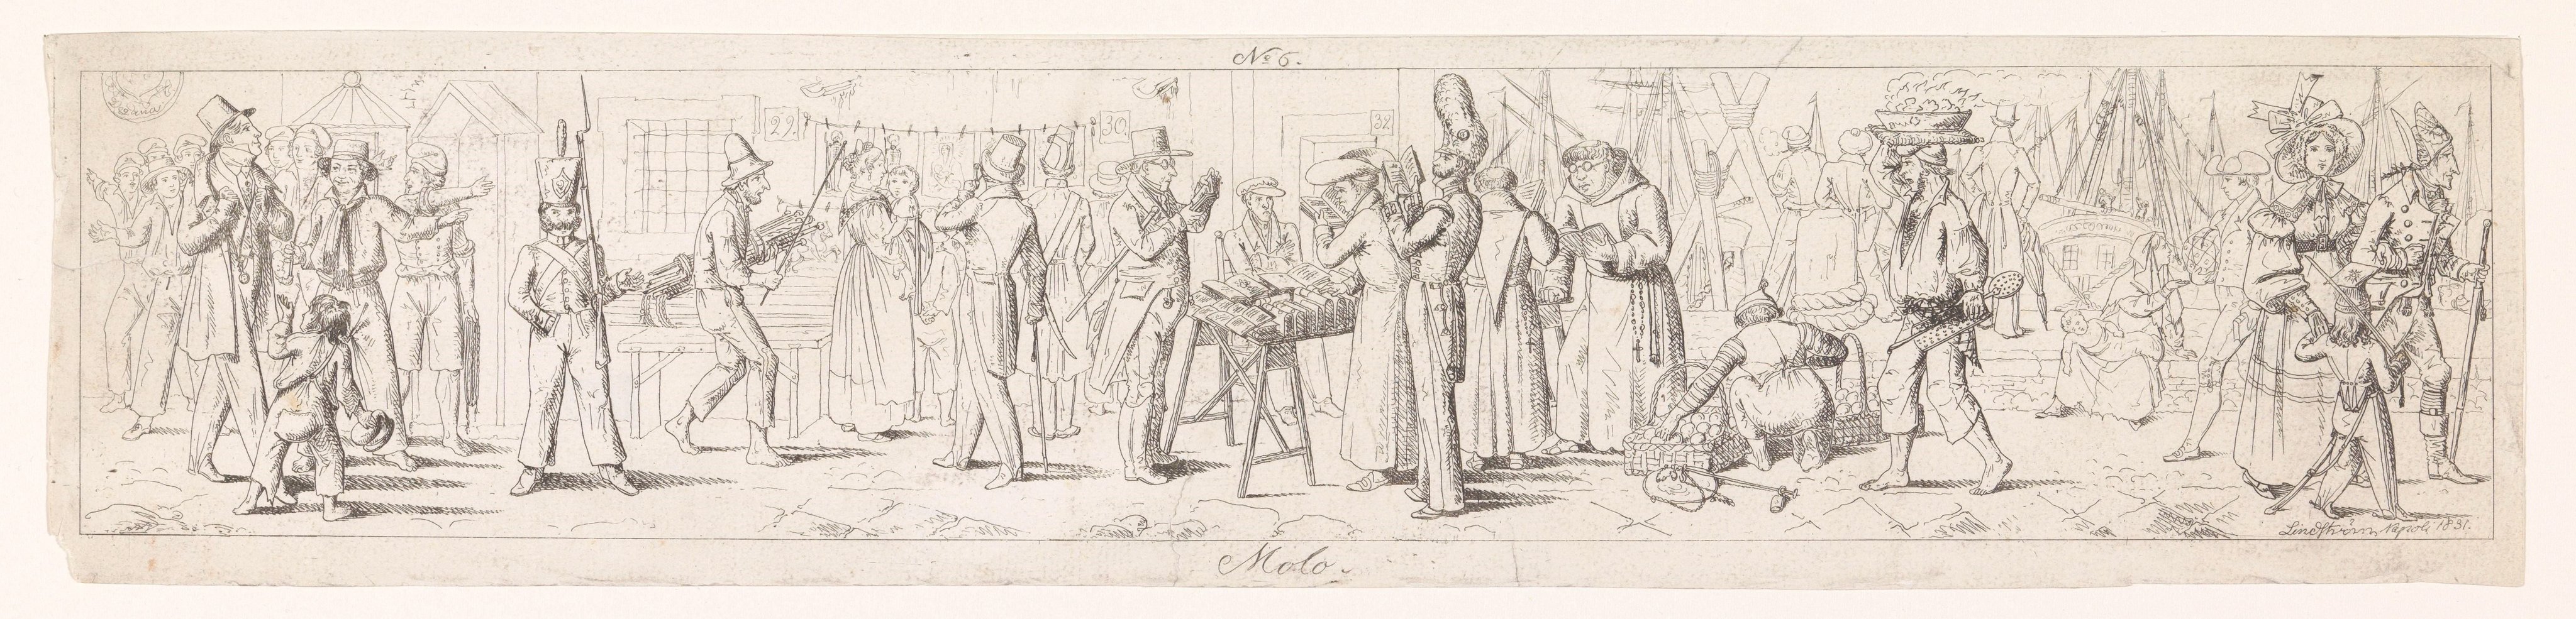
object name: print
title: Panorama delle scene popolari di Napoli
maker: karl johan lindström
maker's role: draughtsman, painter, print maker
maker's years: 1800-1849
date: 1831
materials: paper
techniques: etching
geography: naples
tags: customs, private soldier, art dealer (+ graphic arts), pier, quay, wharf, seaman: sailor, book-shop, bookseller, naples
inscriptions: collector's mark: Lugt 2228, collector's mark: Lugt 4779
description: Links een douanekantoor met zeelieden en een soldaat voor een wachthuisje. In het midden de kramen van een prenthandelaar en een boekhandelaar. Geheel rechts loopt een vrouw arm in arm met een militair; naast hen een jongen verkleed als soldaat. In de achtergrond een bedelares met een kind op haar schoot en de kademuur met de haven.